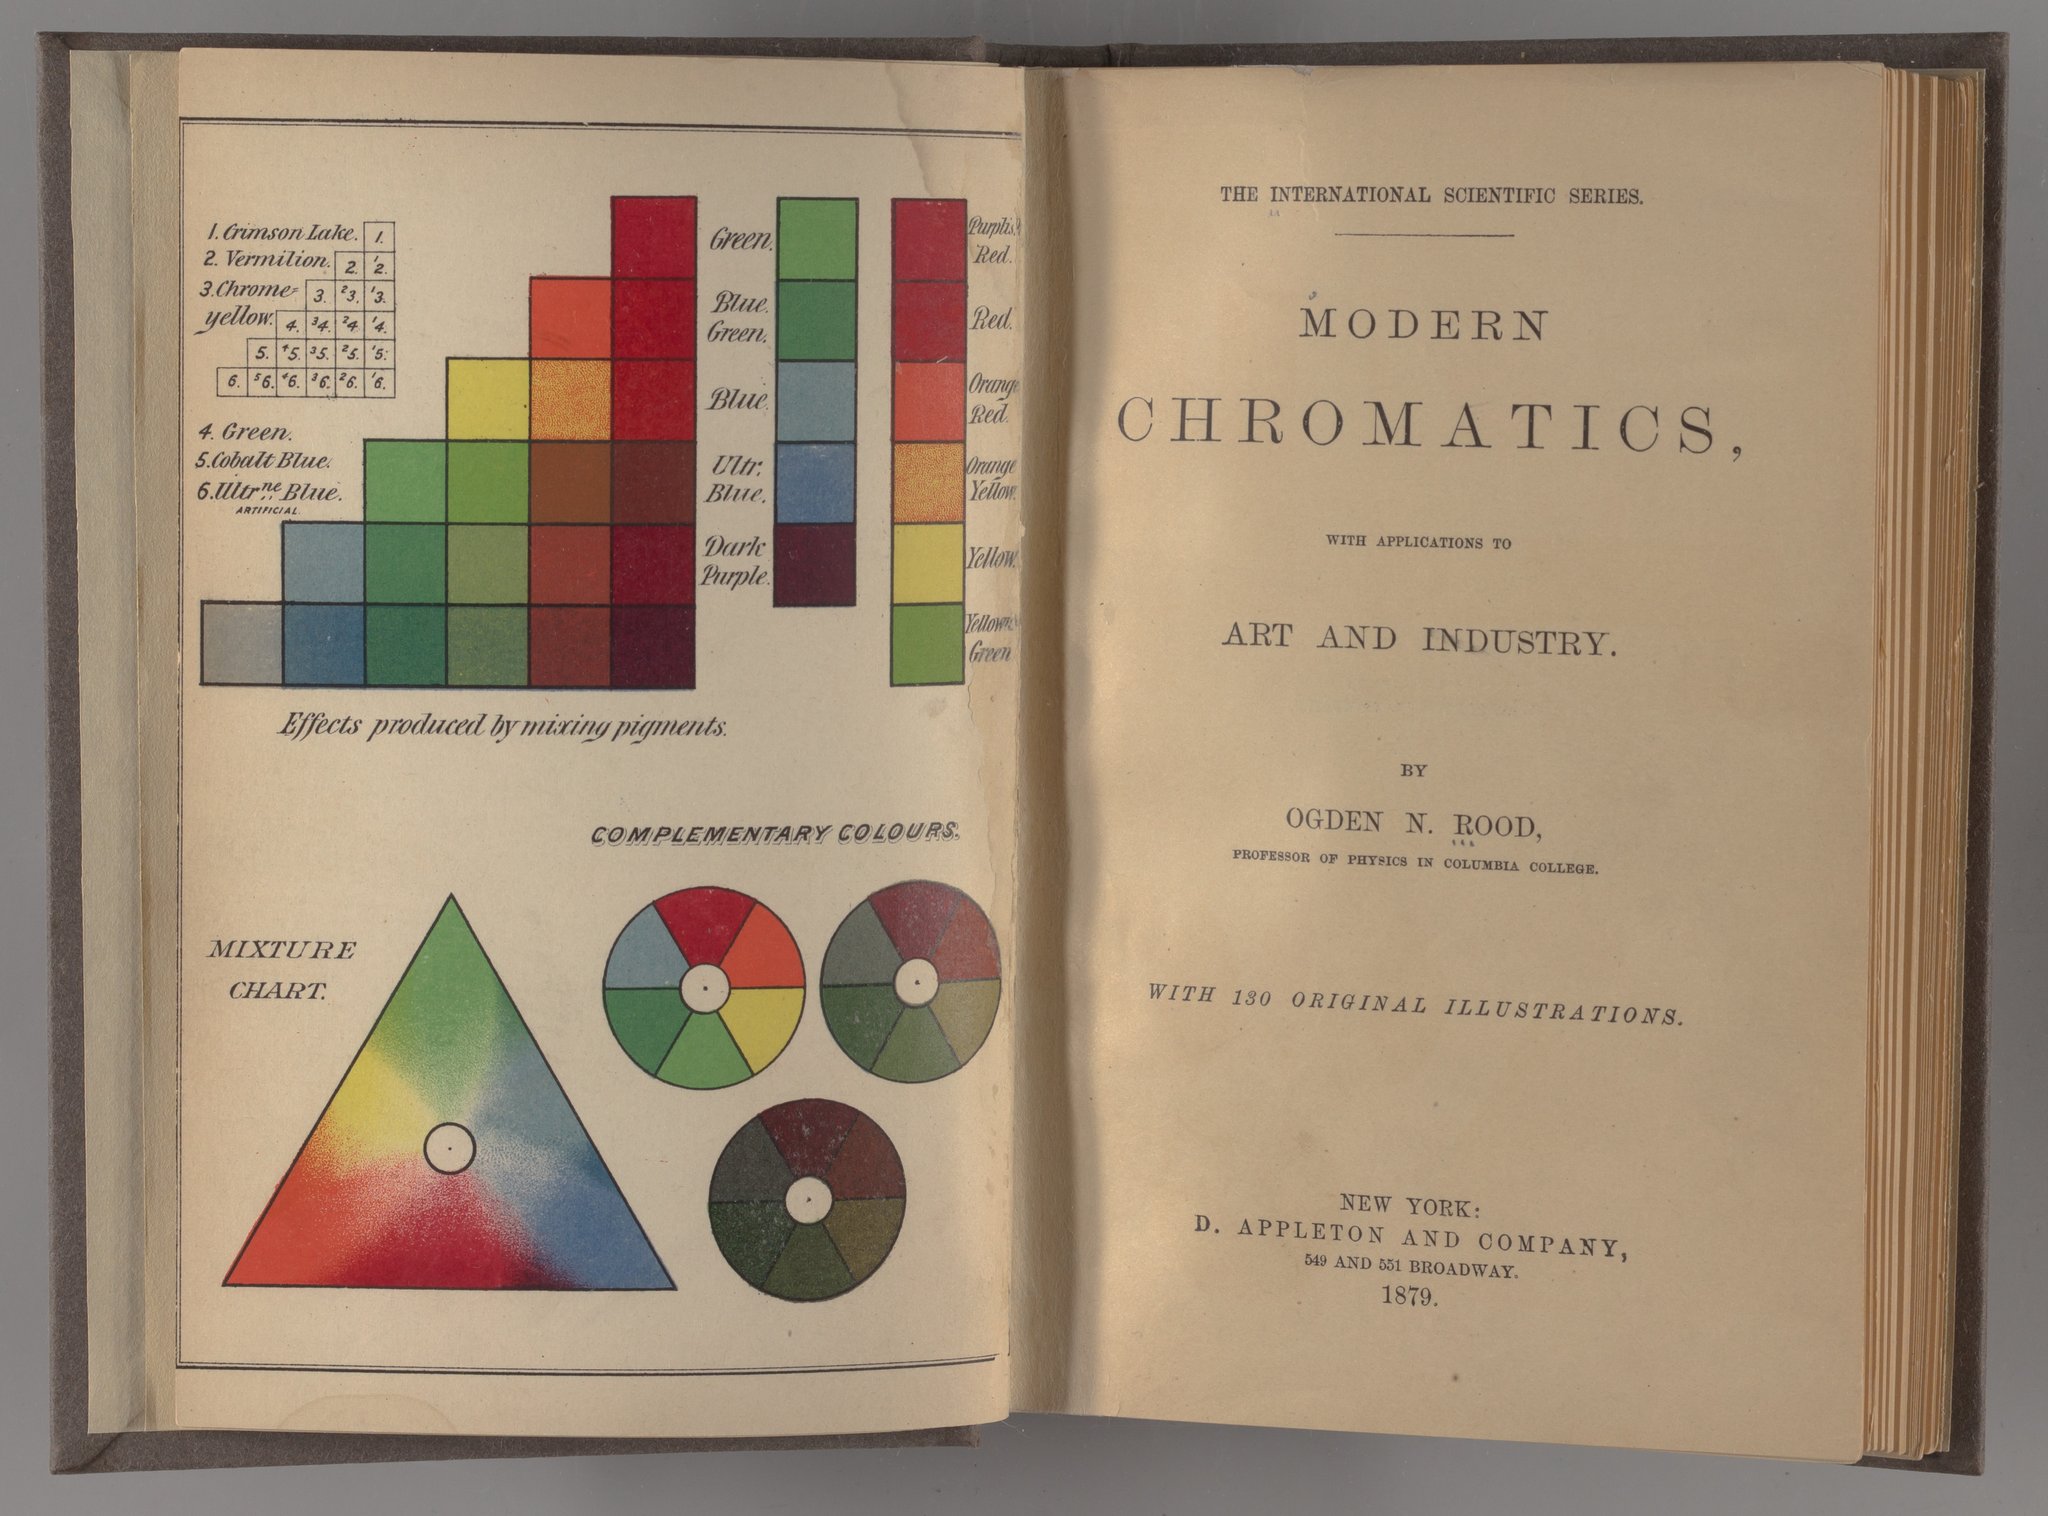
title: Modern chromatics : with applications to art and industry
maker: ogden nicholas rood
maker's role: author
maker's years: 1831-1902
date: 1879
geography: new york